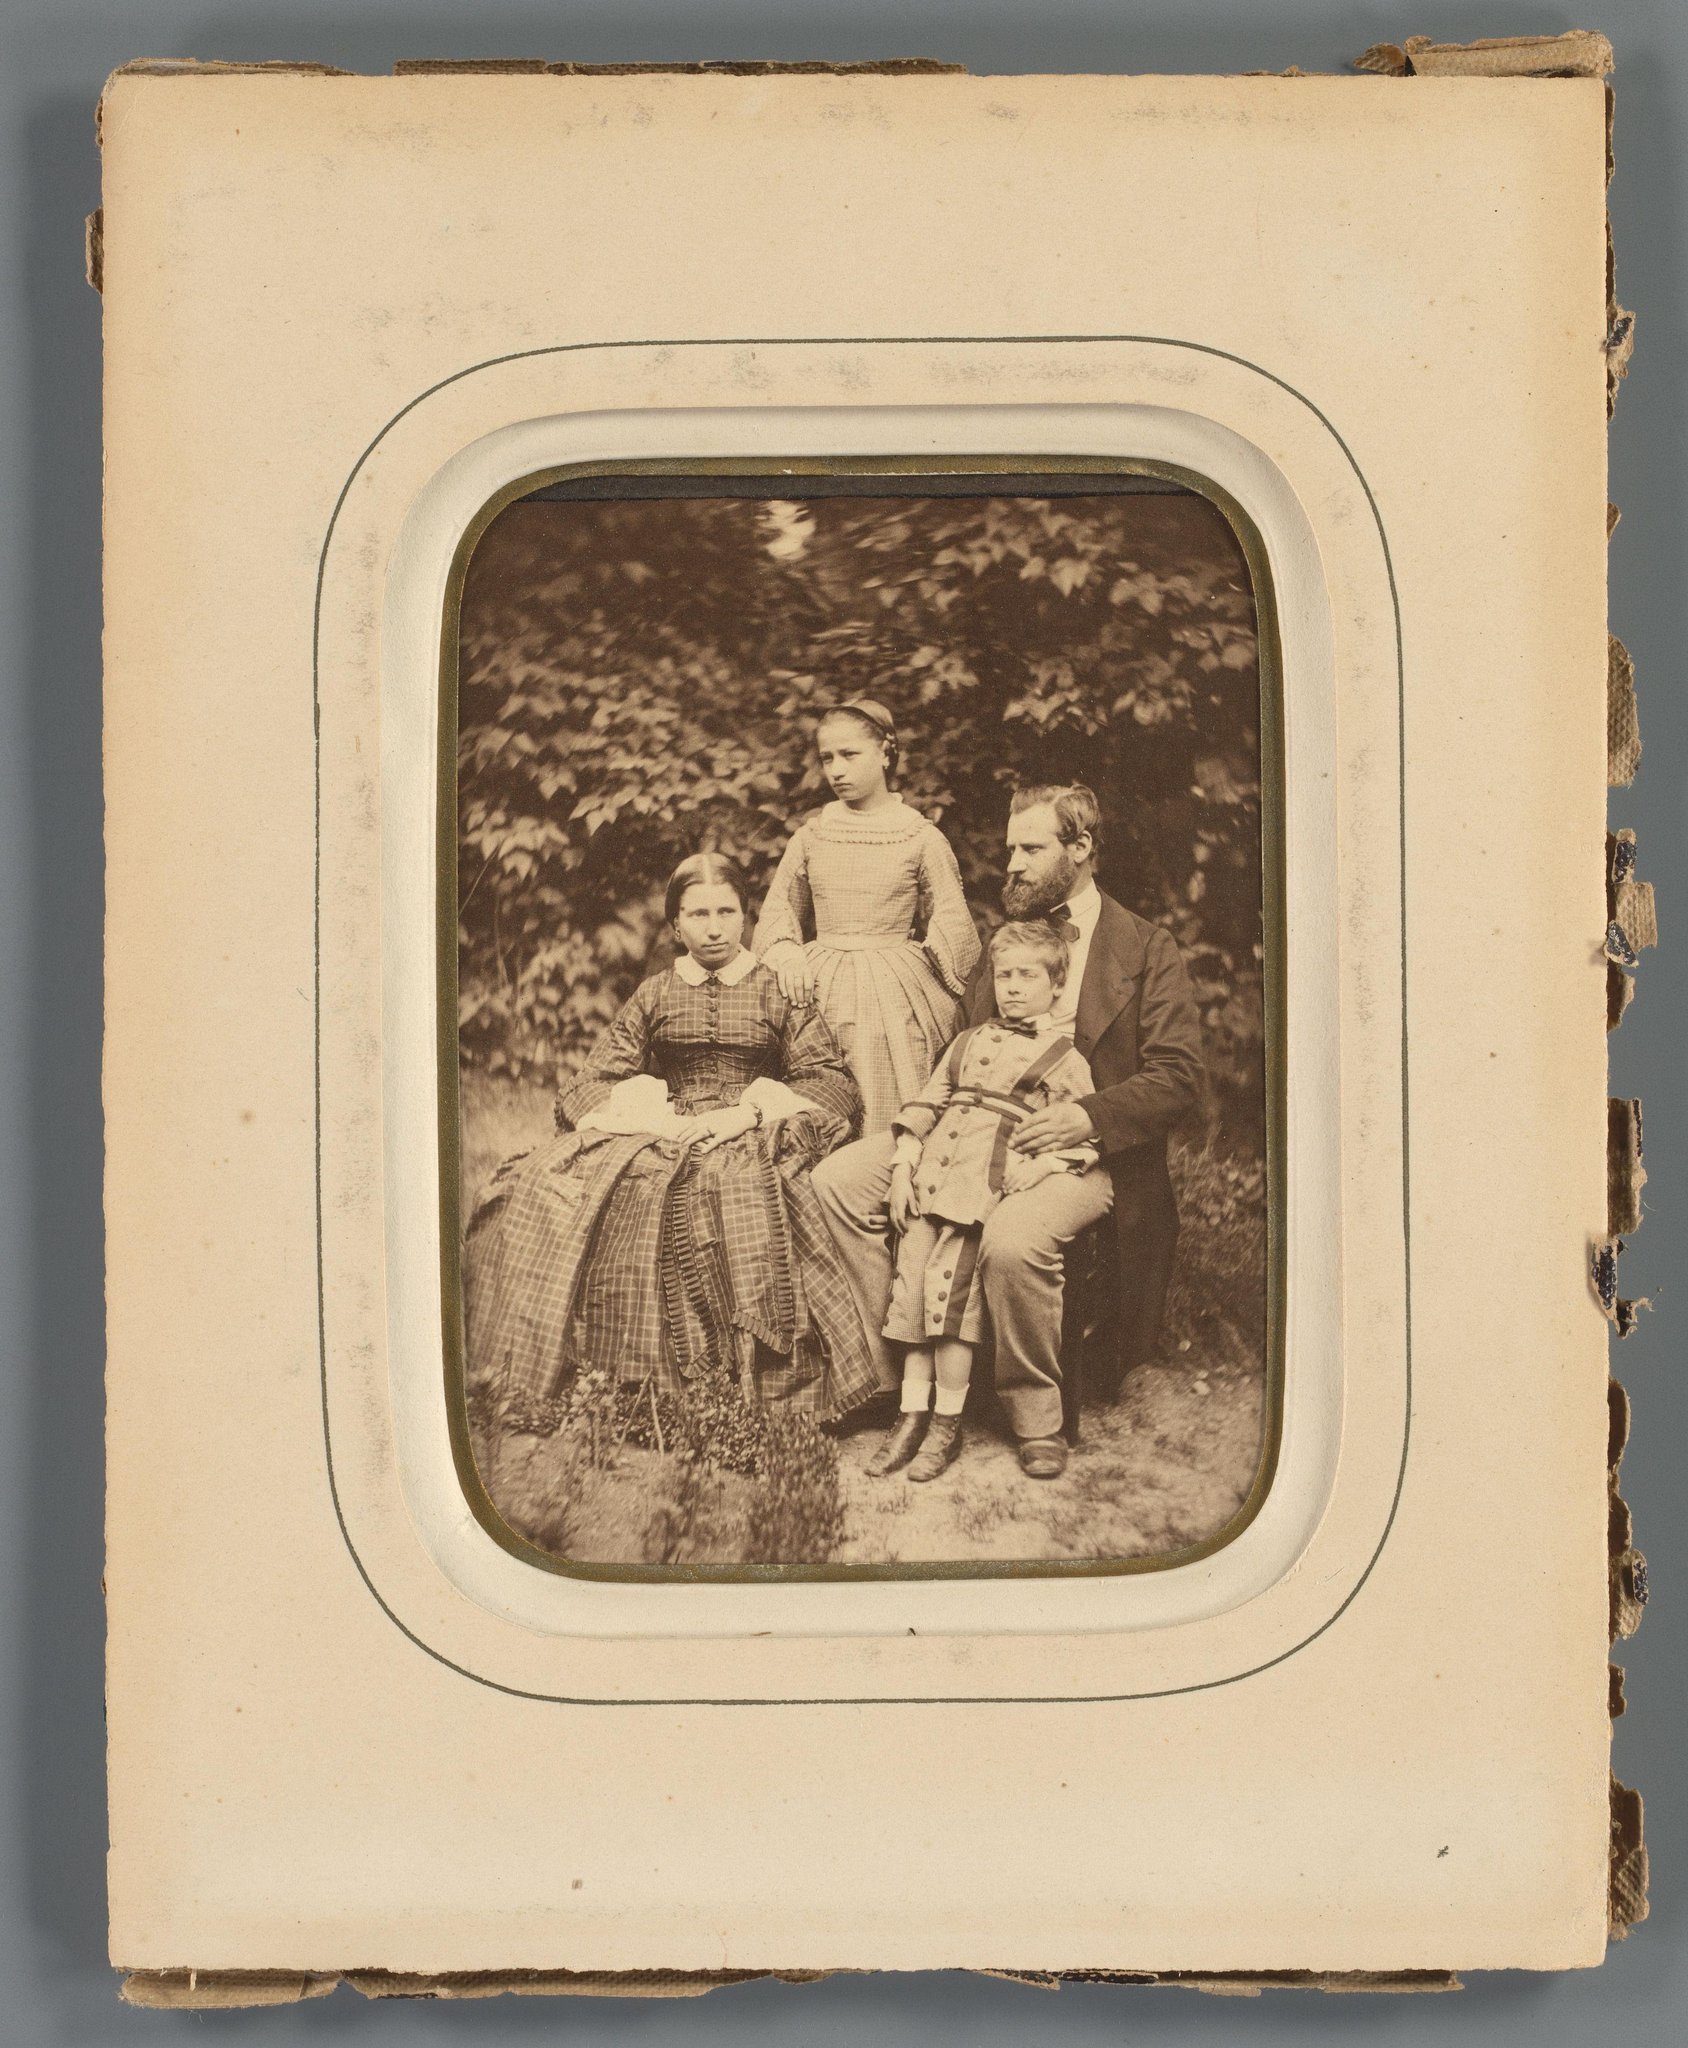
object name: photograph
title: Familieportret met onbekende personen in een tuin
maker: Anonymous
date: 1855-1870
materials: cardboard, paper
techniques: albumen print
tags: family group, especially parents with their child(ren)